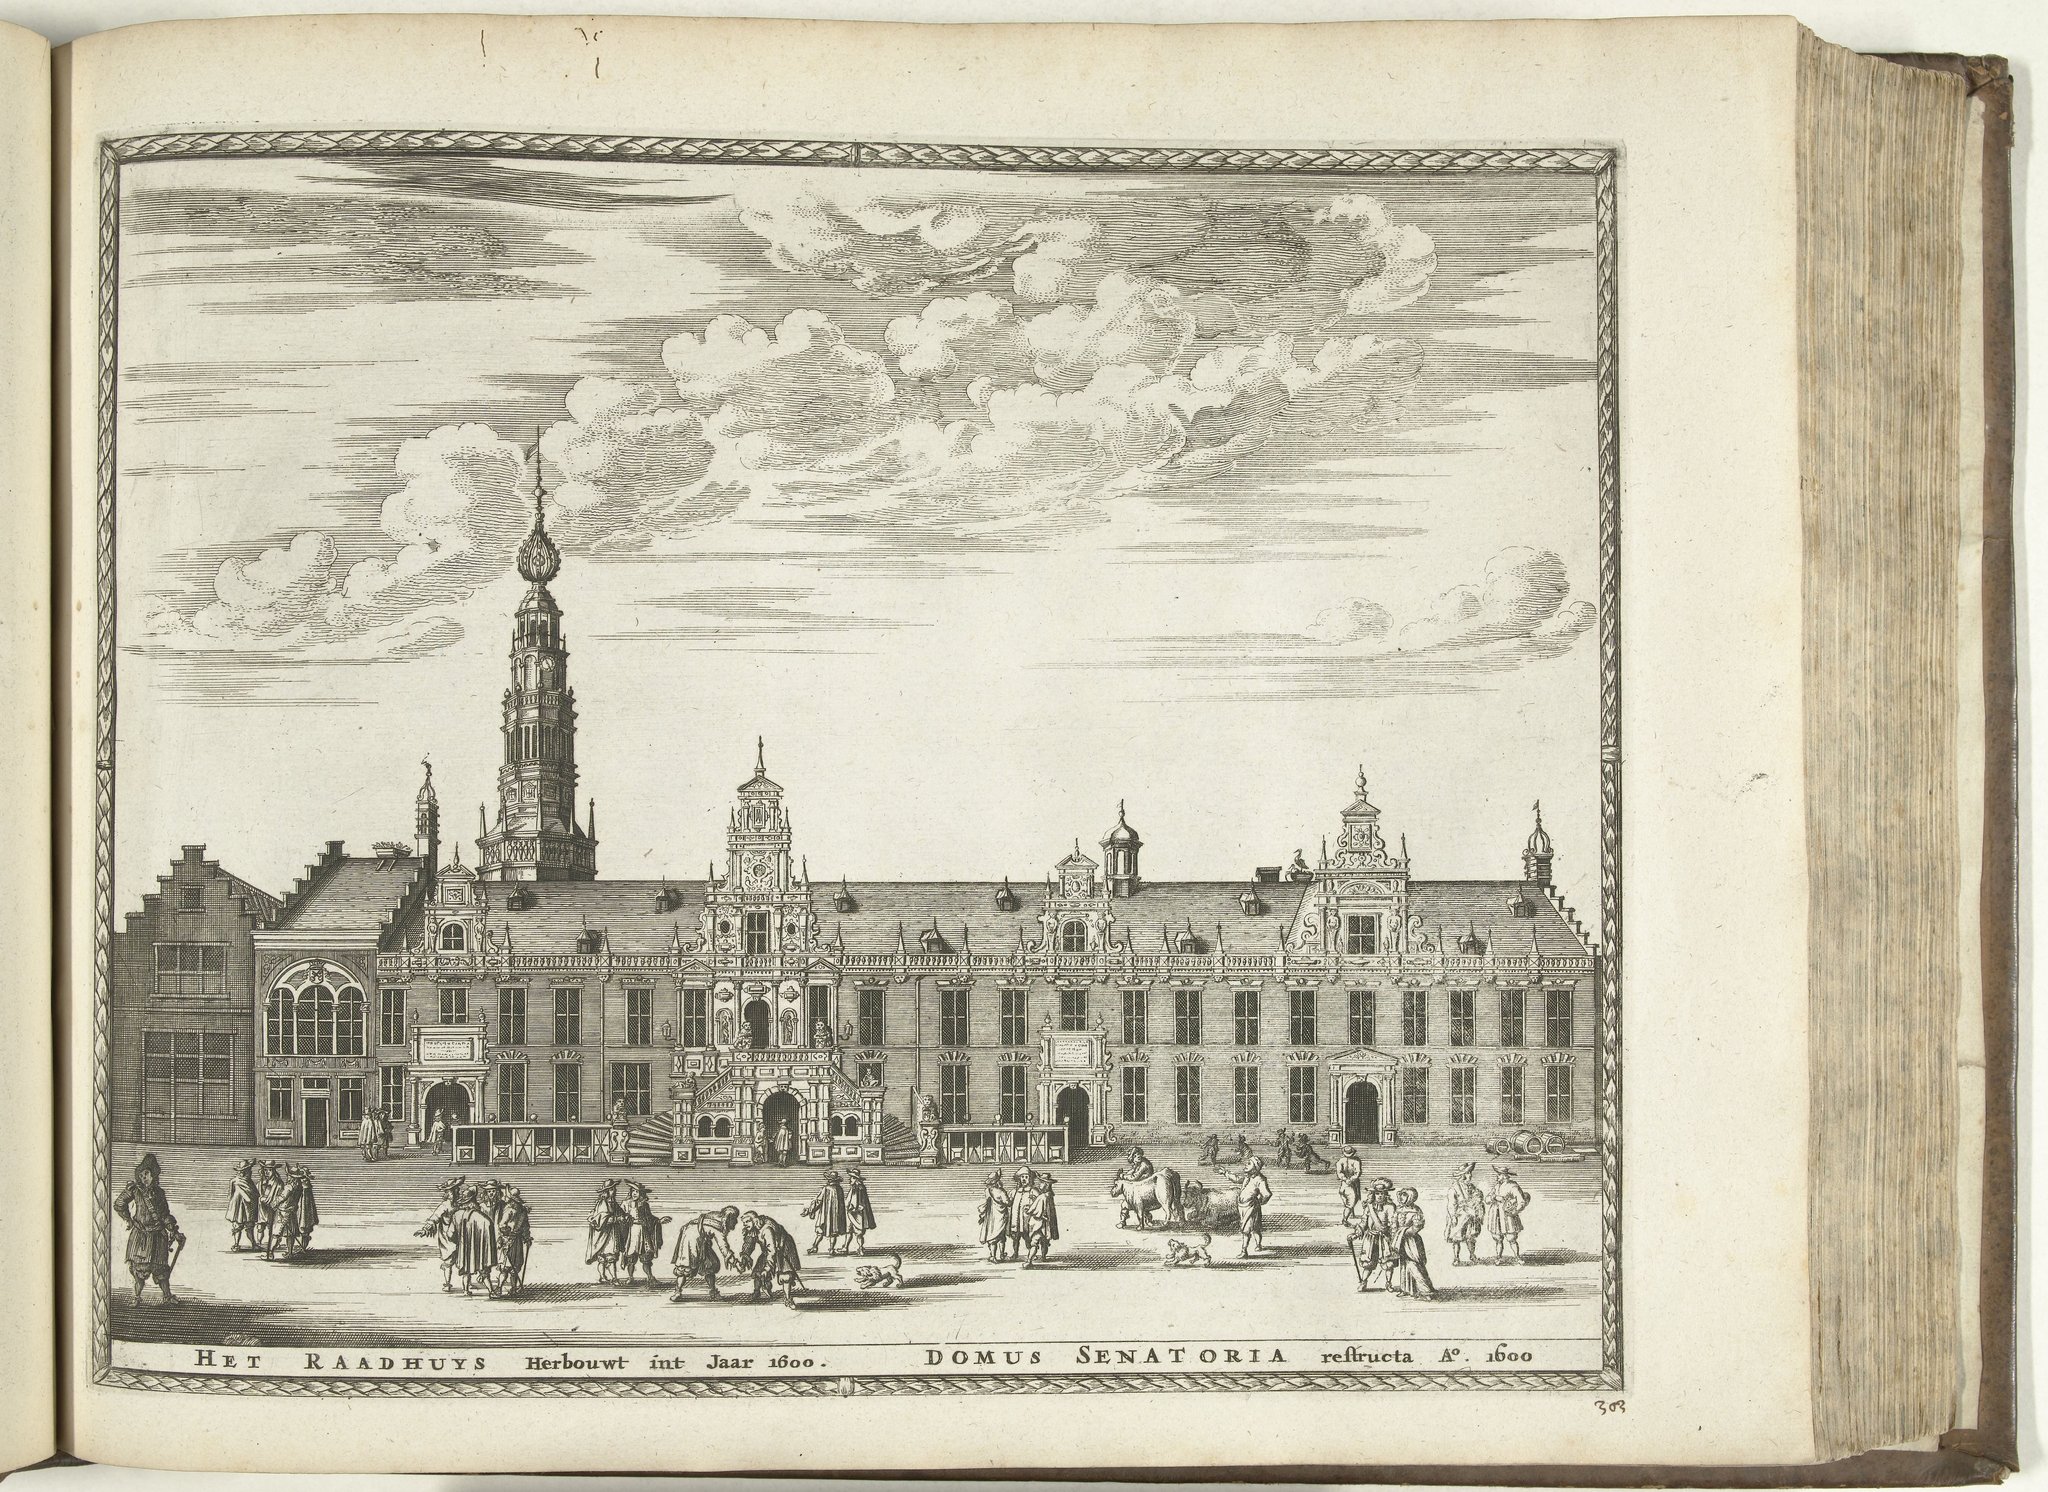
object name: print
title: Les Forces de l'Europe, Asie, Afrique et Amerique (...) Comme aussi les Cartes des Côtes de France et d'Espagne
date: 1726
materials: paper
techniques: etching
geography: leiden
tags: stadhuis, spaanse successieoorlog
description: Gezicht op het raadhuis van Leiden. Plaat nr. 303 in deel XIII van het prentwerk: Les Forces de l'Europe, Asie, Afrique et Amerique ... Comme aussi les Cartes des Côtes de France et d'Espagne uit 1726, dit tweede deel met 271 met de hand genummerde platen van vermaarde sterke steden en vestingen in het kader van de Spaanse Successieoorlog 1701-1713. Voor het merendeel zijn deze platen gekopieerd naar de anonieme Franse platen van vermaarde sterke steden en vestingen: in Les forces de l'Europe en in: Le theatre de la guerre, dans les Pays-Bas, beide oorspronkelijk uitgegeven door Nicolas de Fer te Parijs (1693-1697) in het kader van de Negenjarige Oorlog. Titels in het Nederlands en Latijn.